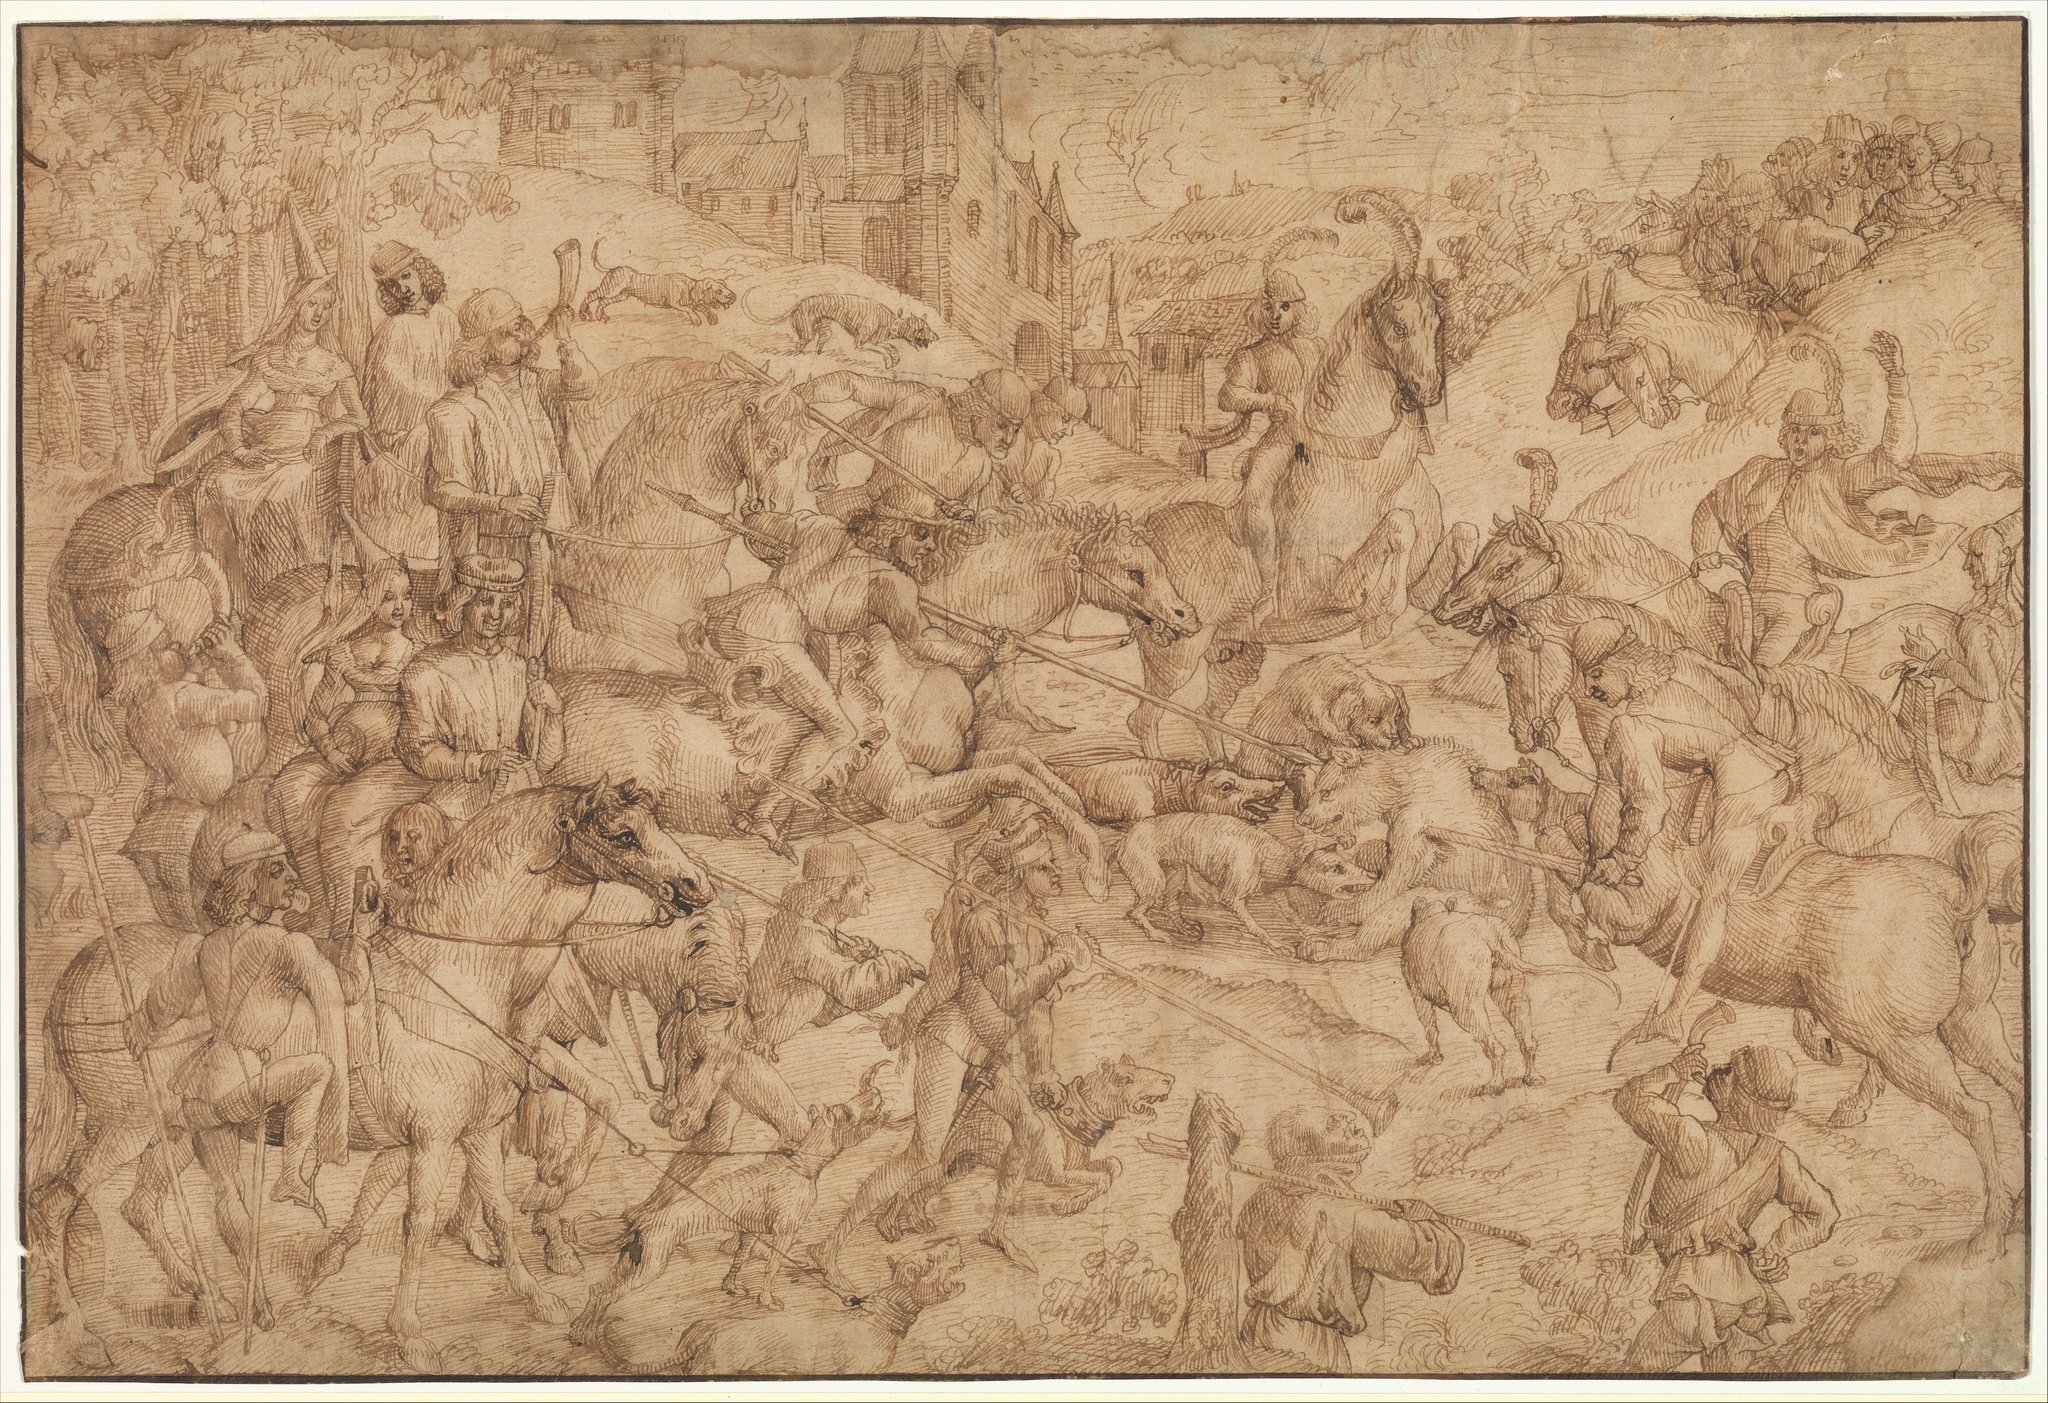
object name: drawing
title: Bear Hunt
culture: flemish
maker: flanders (brussels?)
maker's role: artist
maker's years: 1470-1490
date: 1470-1490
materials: ink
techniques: pen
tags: bears,men,hunting,dogs,horses